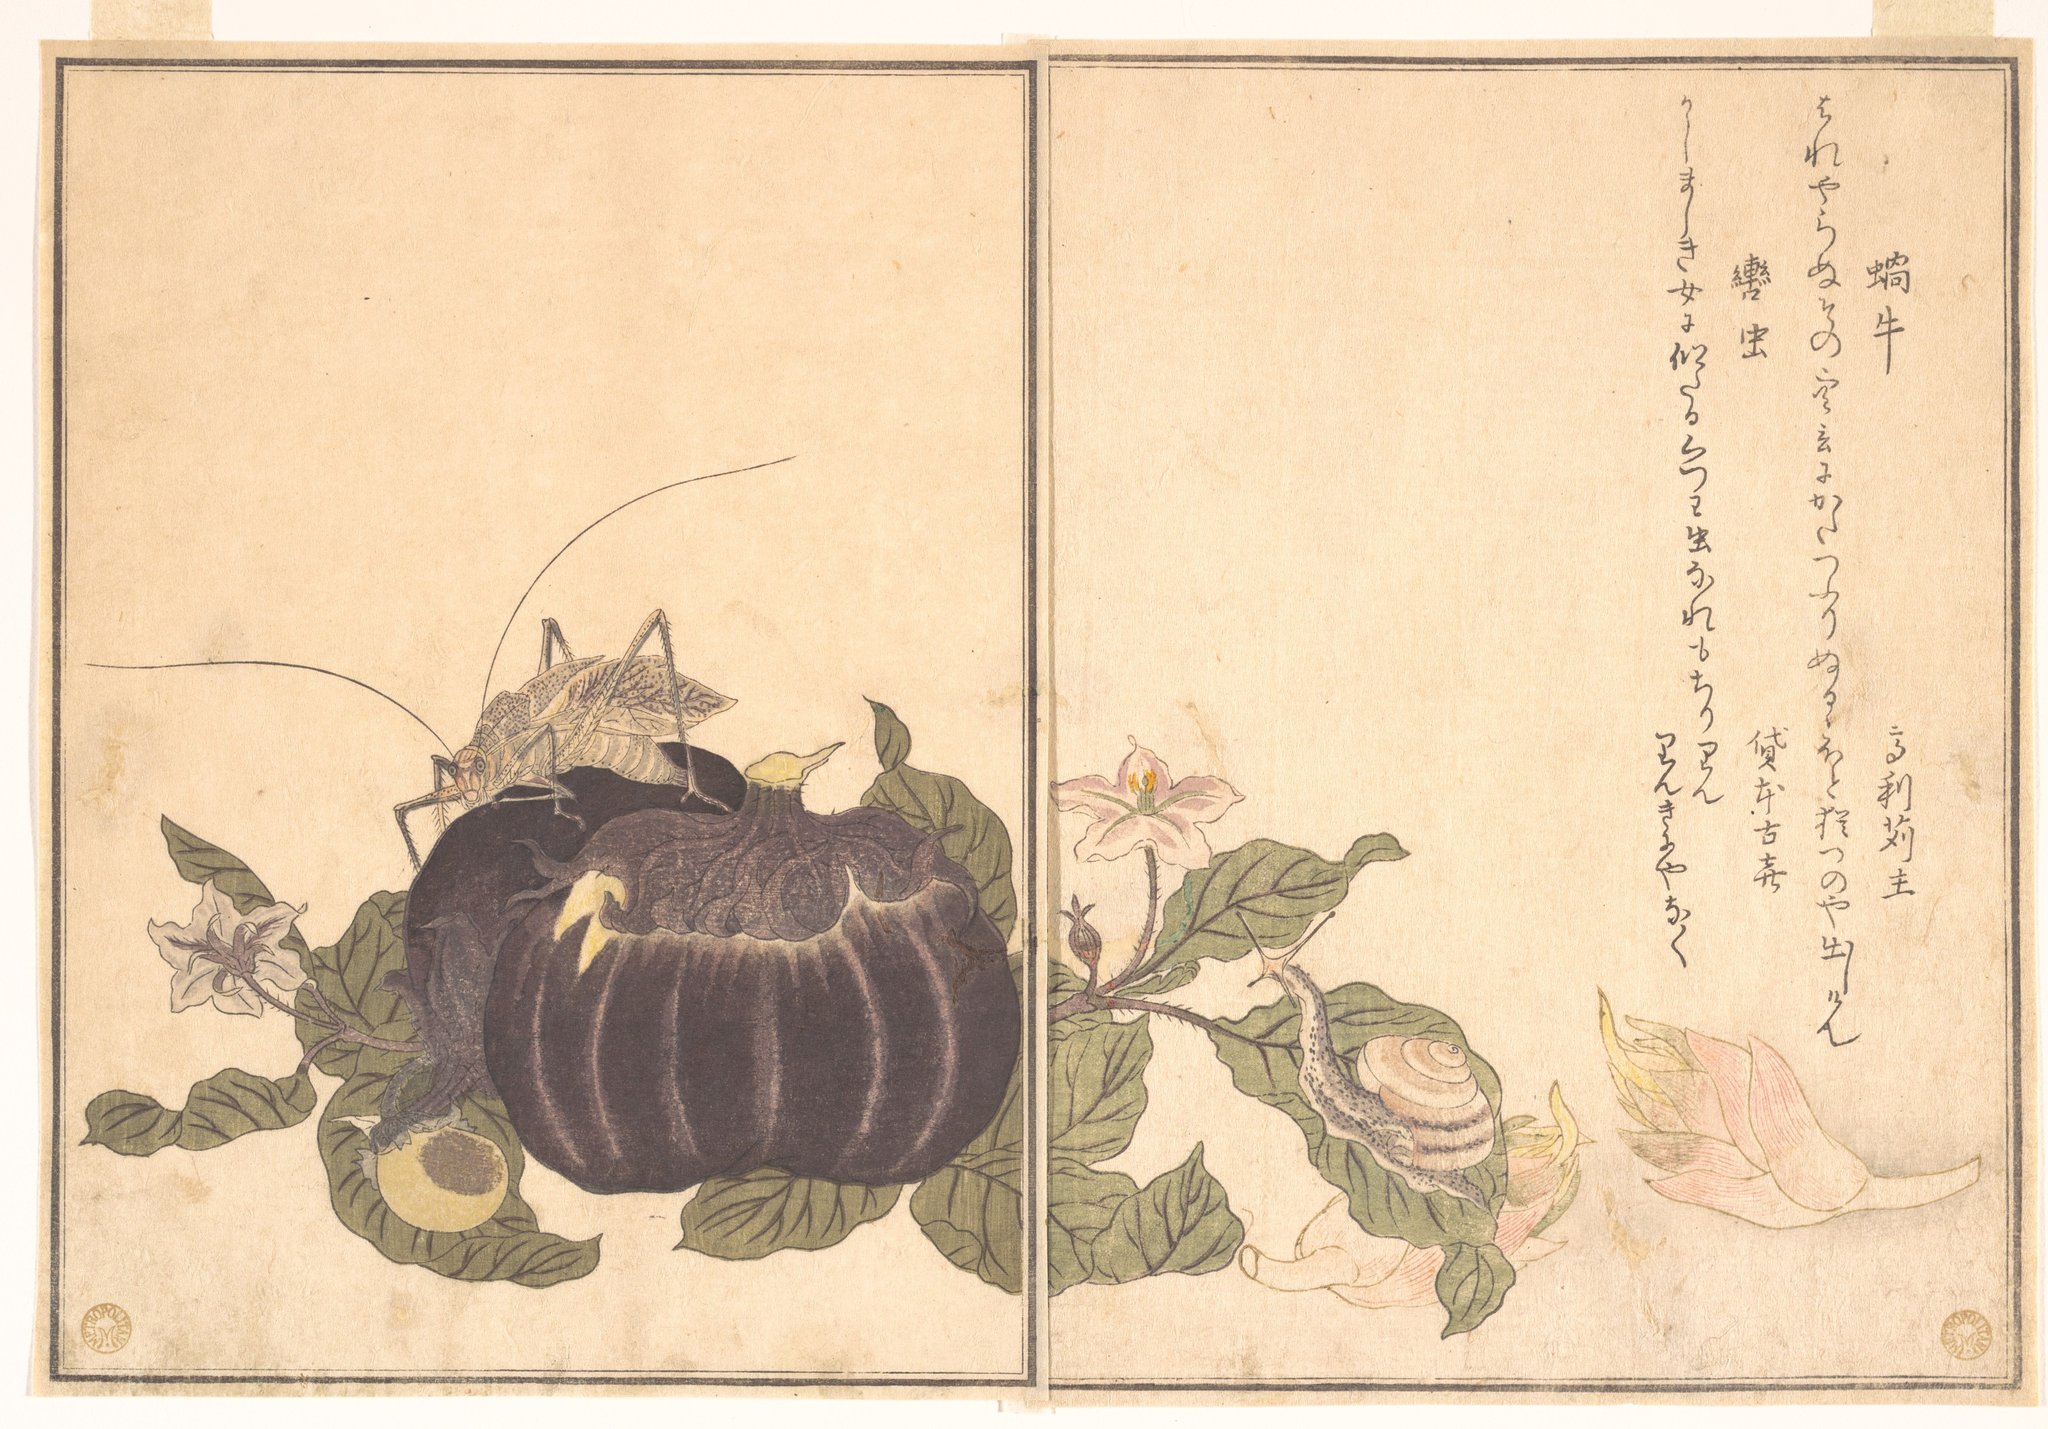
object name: woodblock print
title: Land Snail (Katatsumuri); Giant Katydid (Kutsuwamushi), from the Picture Book of Crawling Creatures (Ehon mushi erami)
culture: japanese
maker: kitagawa utamaro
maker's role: artist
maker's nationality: japanese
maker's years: 1754-1806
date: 1788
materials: ink, paper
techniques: woodblock print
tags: vegetables,insects,snails